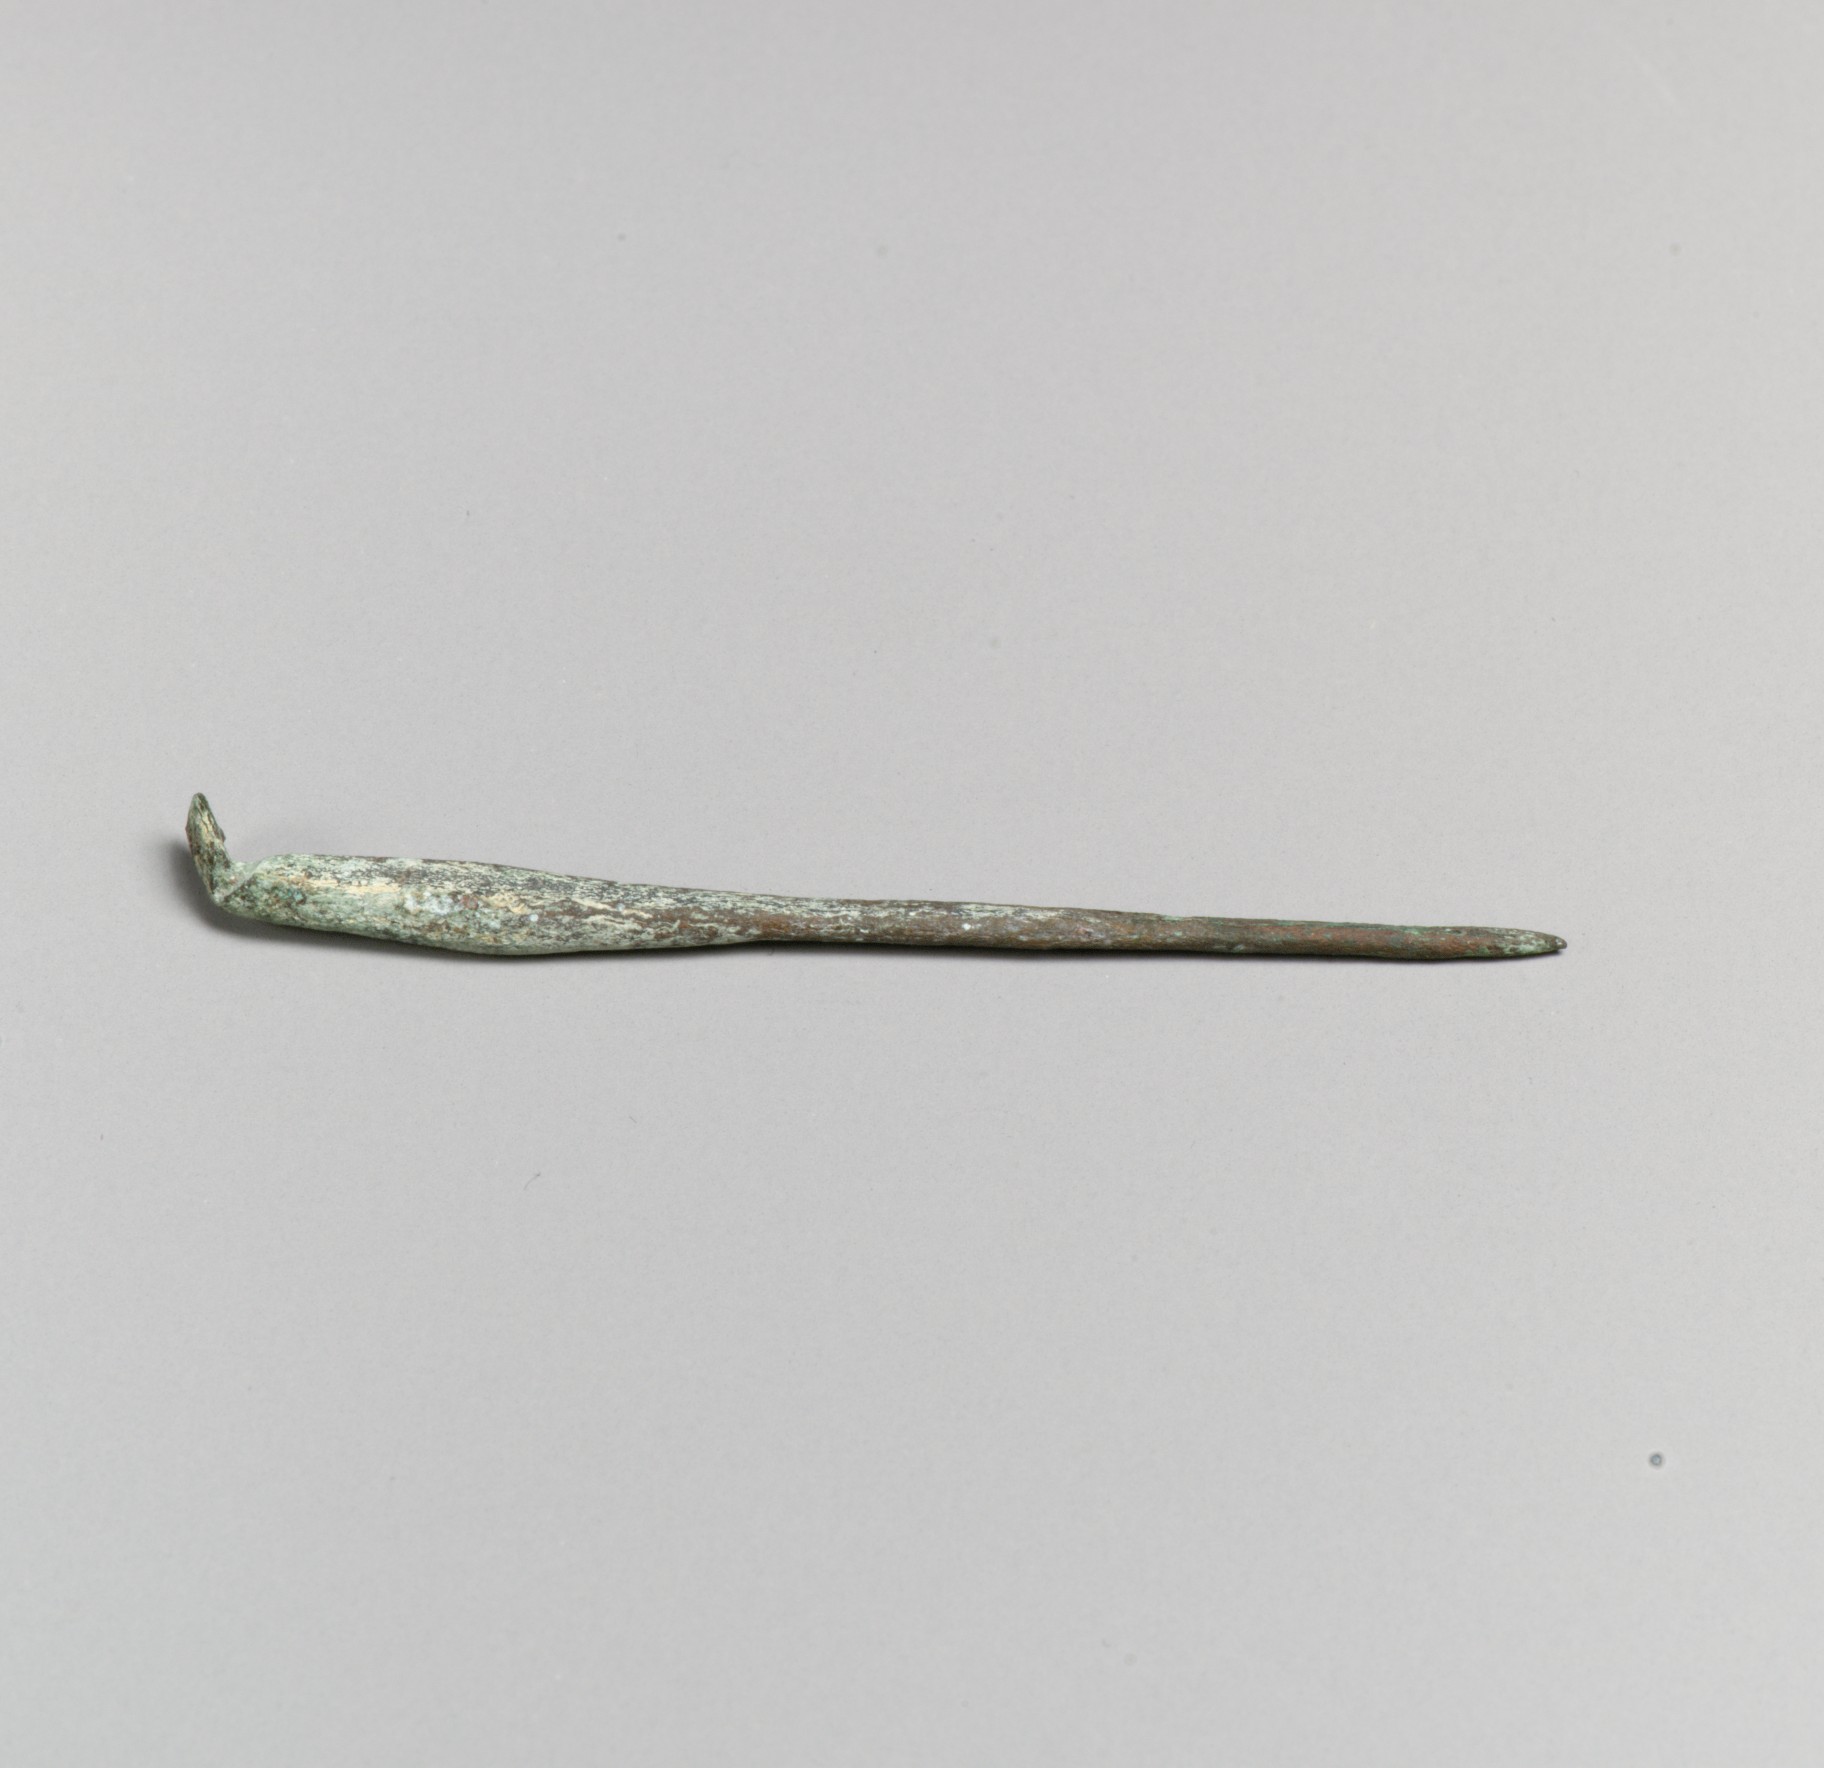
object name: spoon or ligula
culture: roman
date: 670 BCE-330 CE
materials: bronze